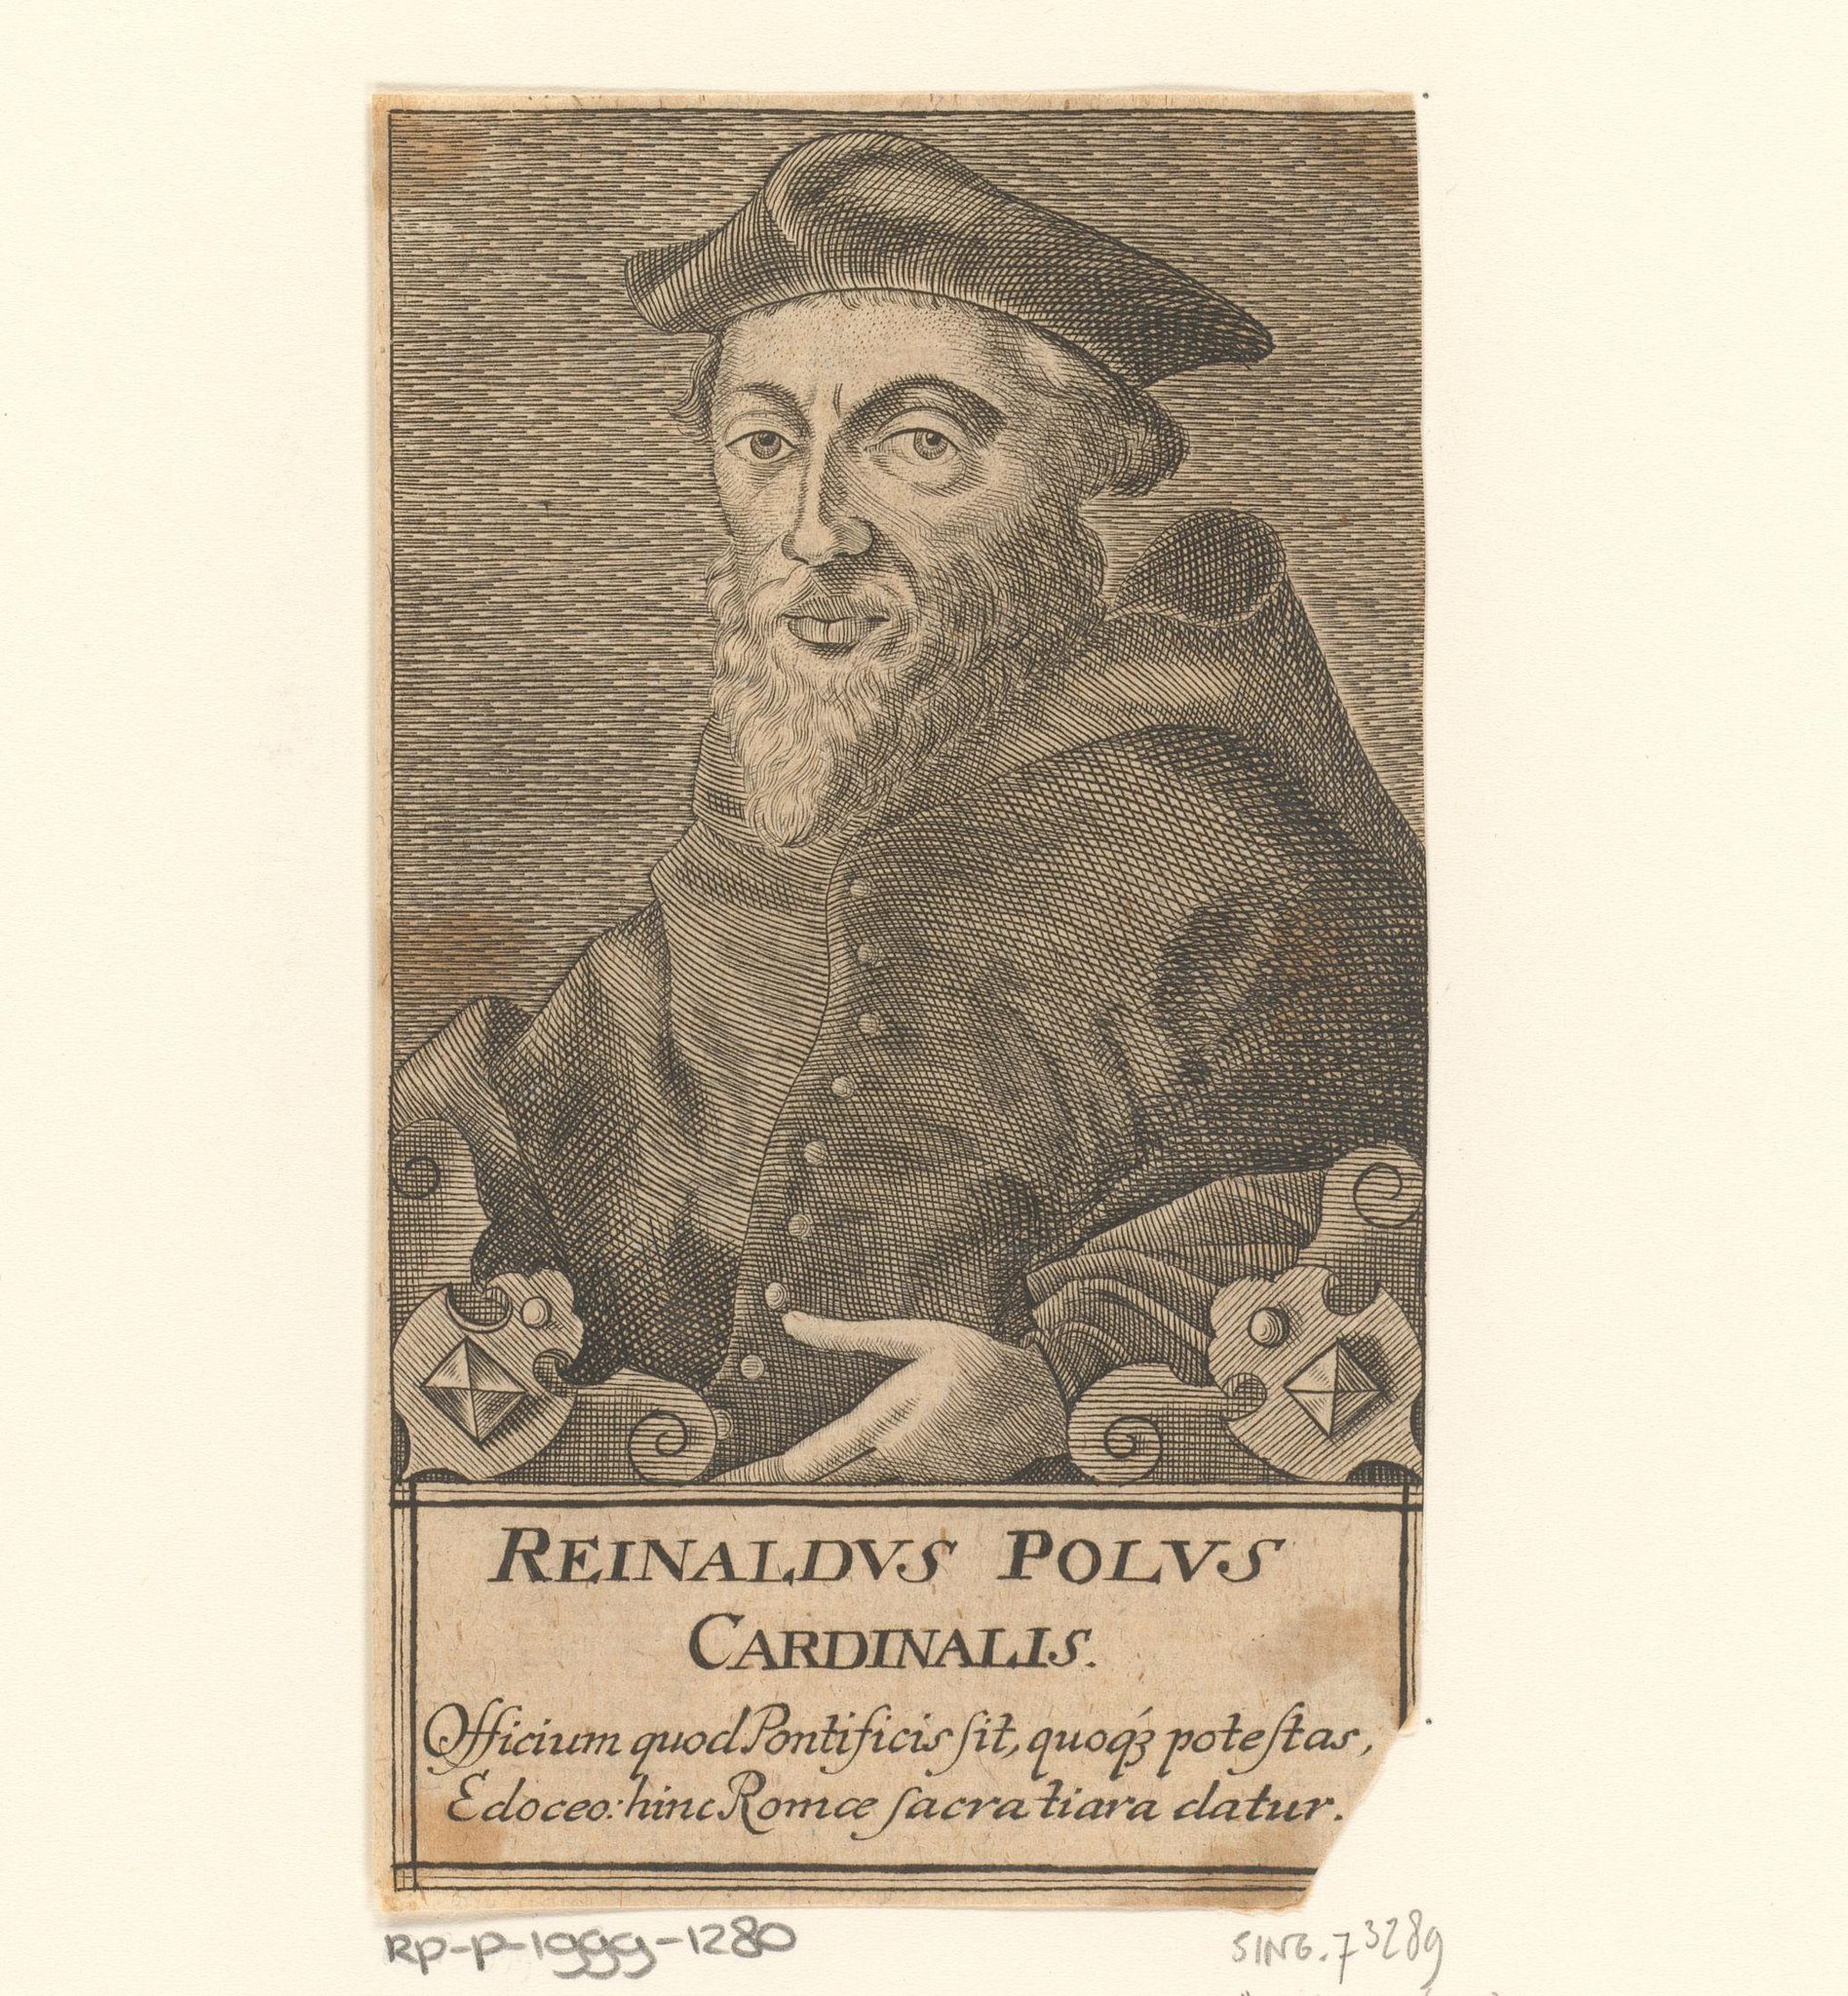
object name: print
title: Portret van Reginald Pole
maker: Anonymous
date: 1722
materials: paper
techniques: engraving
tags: london, cardinal, historical persons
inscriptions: collector's mark: Lugt 2760, collector's mark: Lugt 2228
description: Prent mogelijk uit: Fortgesetzte Sammlung Von Alten und Neuen Theologischen Sachen (...). Leipzig: erven Johann Friedrich Brauns, 1722.